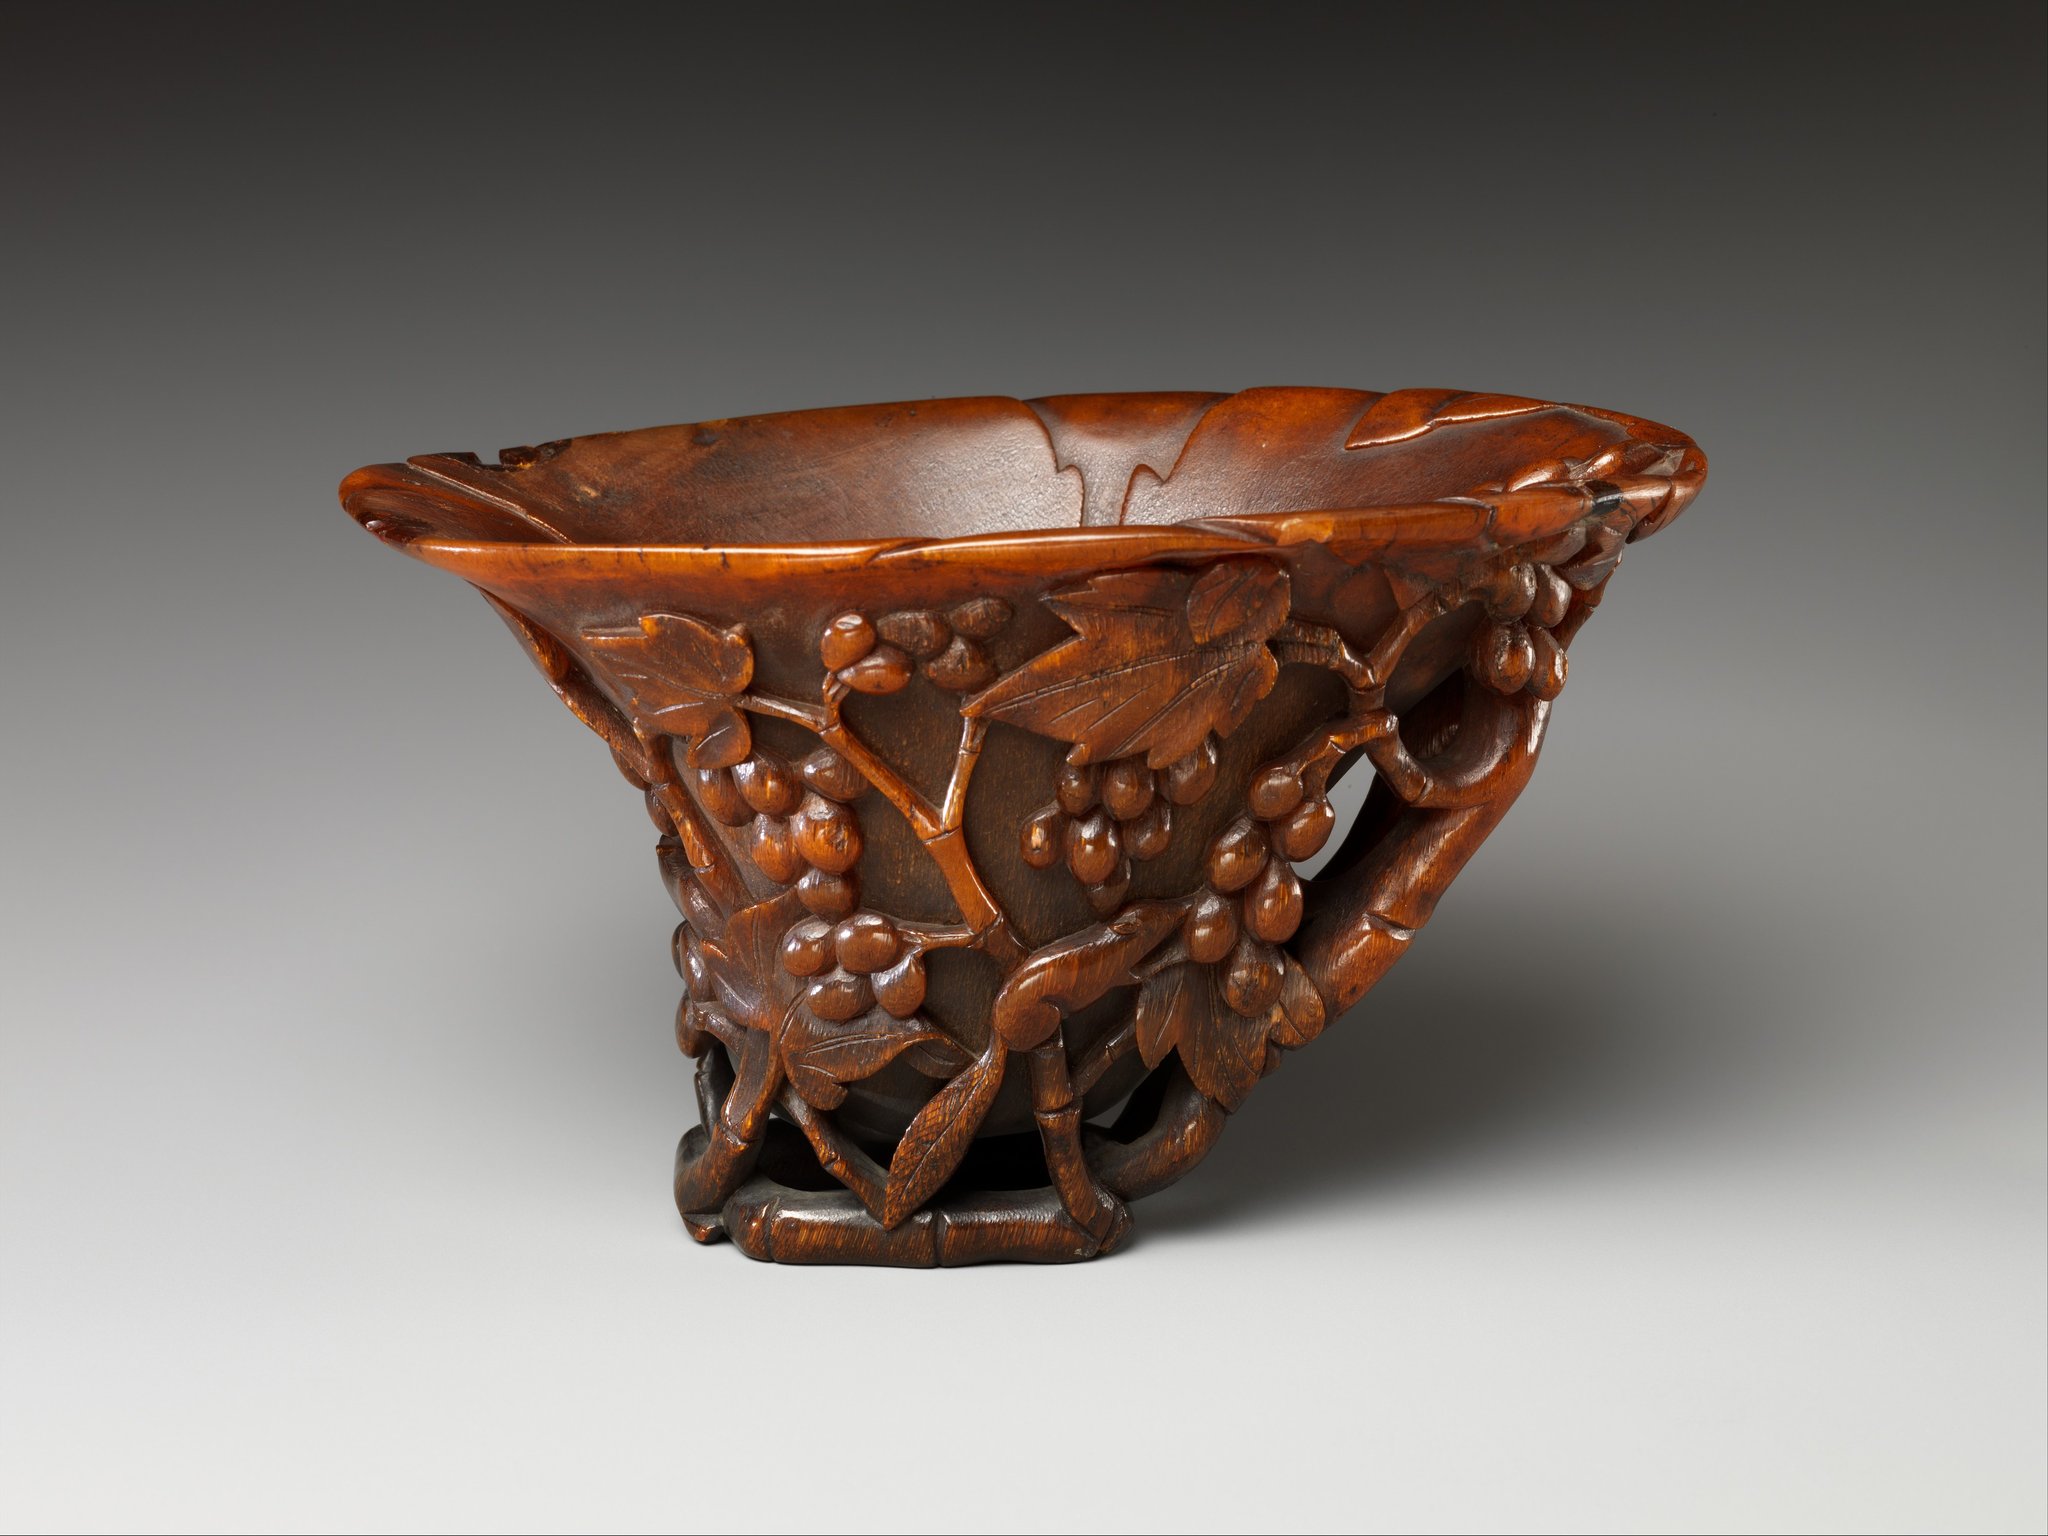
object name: cup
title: Cup with grapes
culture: chinese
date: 1601-1700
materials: horn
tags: grapes